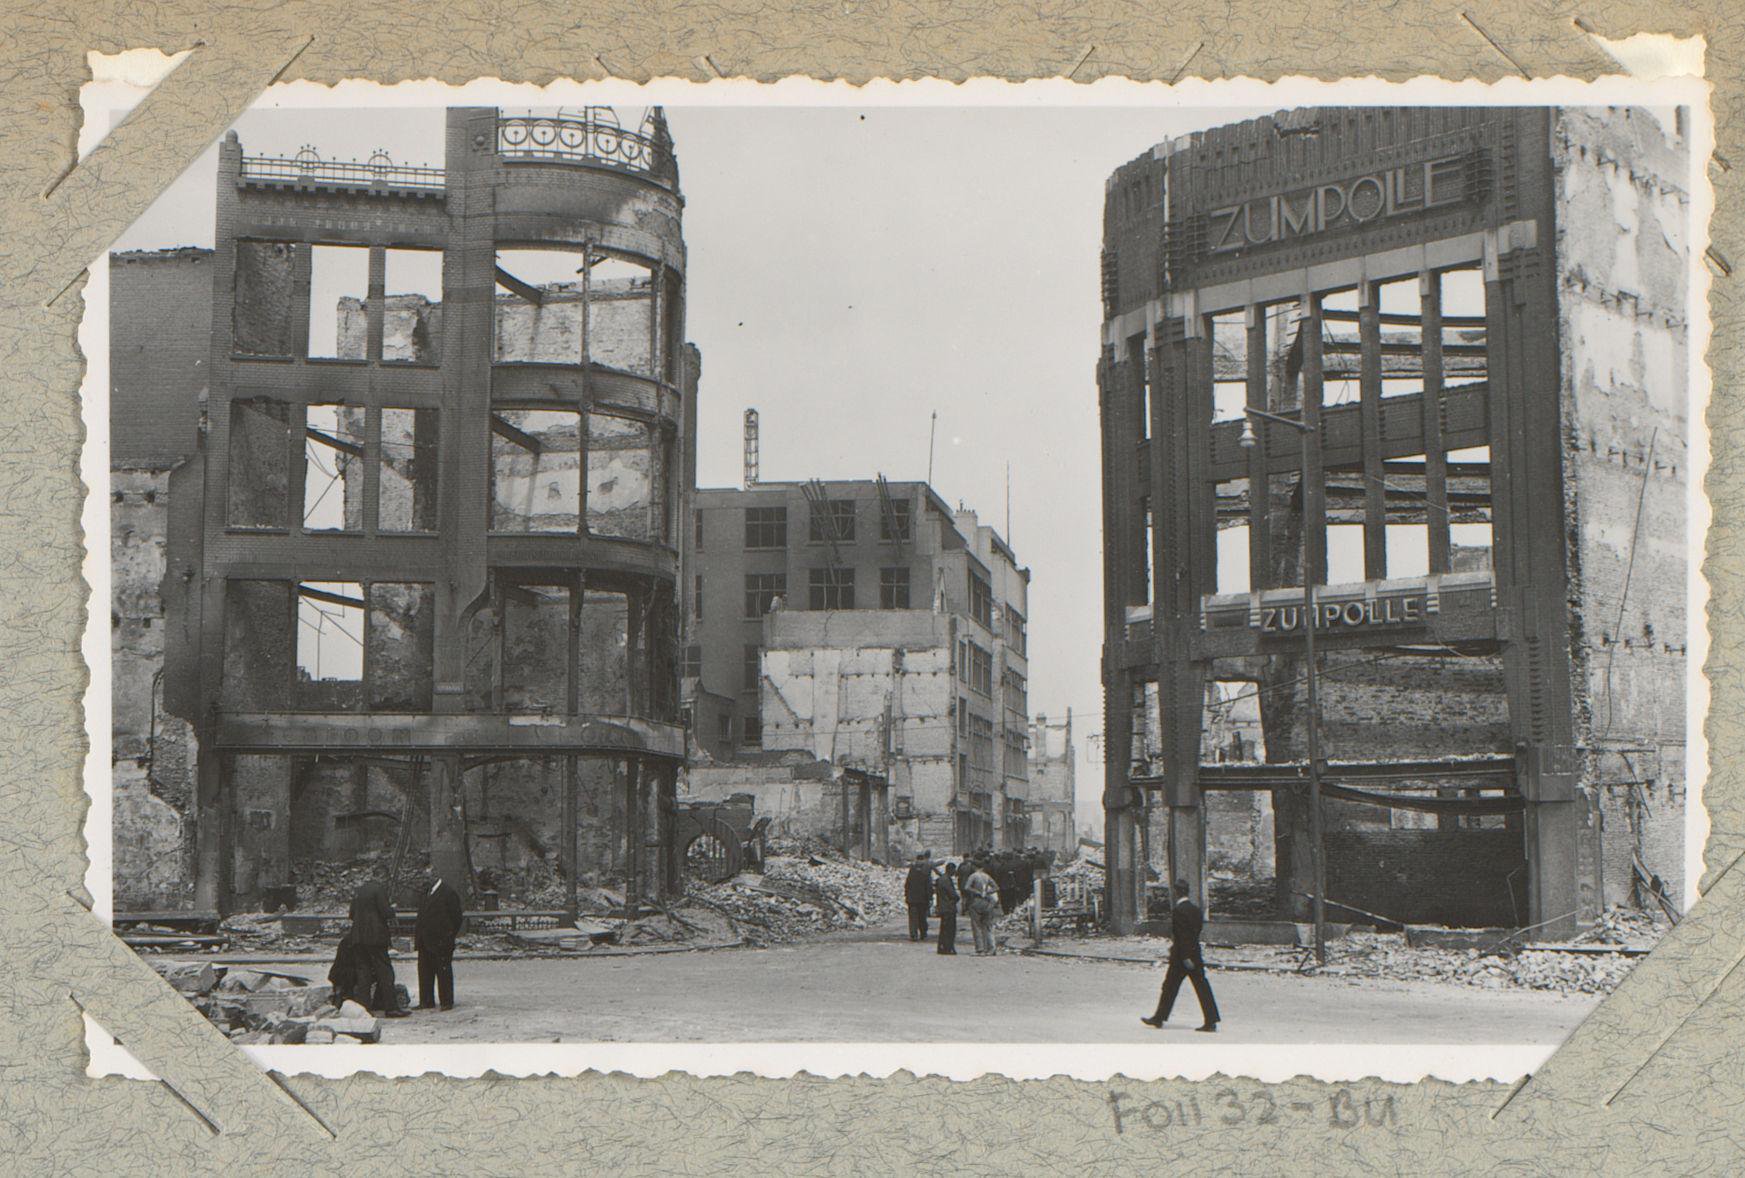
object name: photograph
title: Ruïnes bij de Hoofdsteeg te Rotterdam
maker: j. nolte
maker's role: fotograaf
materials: photographic support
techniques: gelatin silver print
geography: rotterdam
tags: devastated, ruined place or city (~ warfare), street, ruin of a dwelling, house, castle, etc., rotterdam, rotterdam blitz